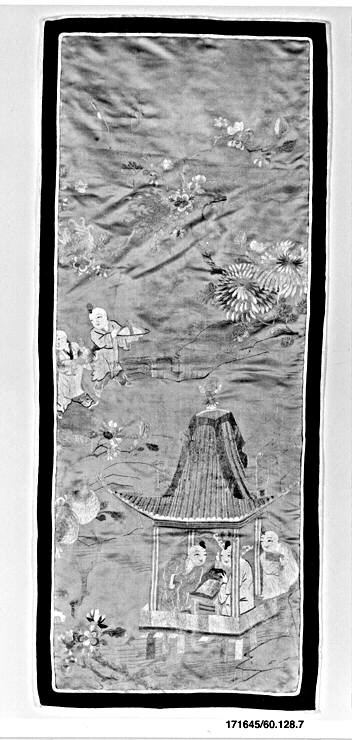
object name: vertical panel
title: Vertical Panel with Scholars in Pavilion and Children Playing in Garden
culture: chinese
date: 1601-1700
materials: cotton, metal thread, silk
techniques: bookbinding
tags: gardens,boys,men,flowers